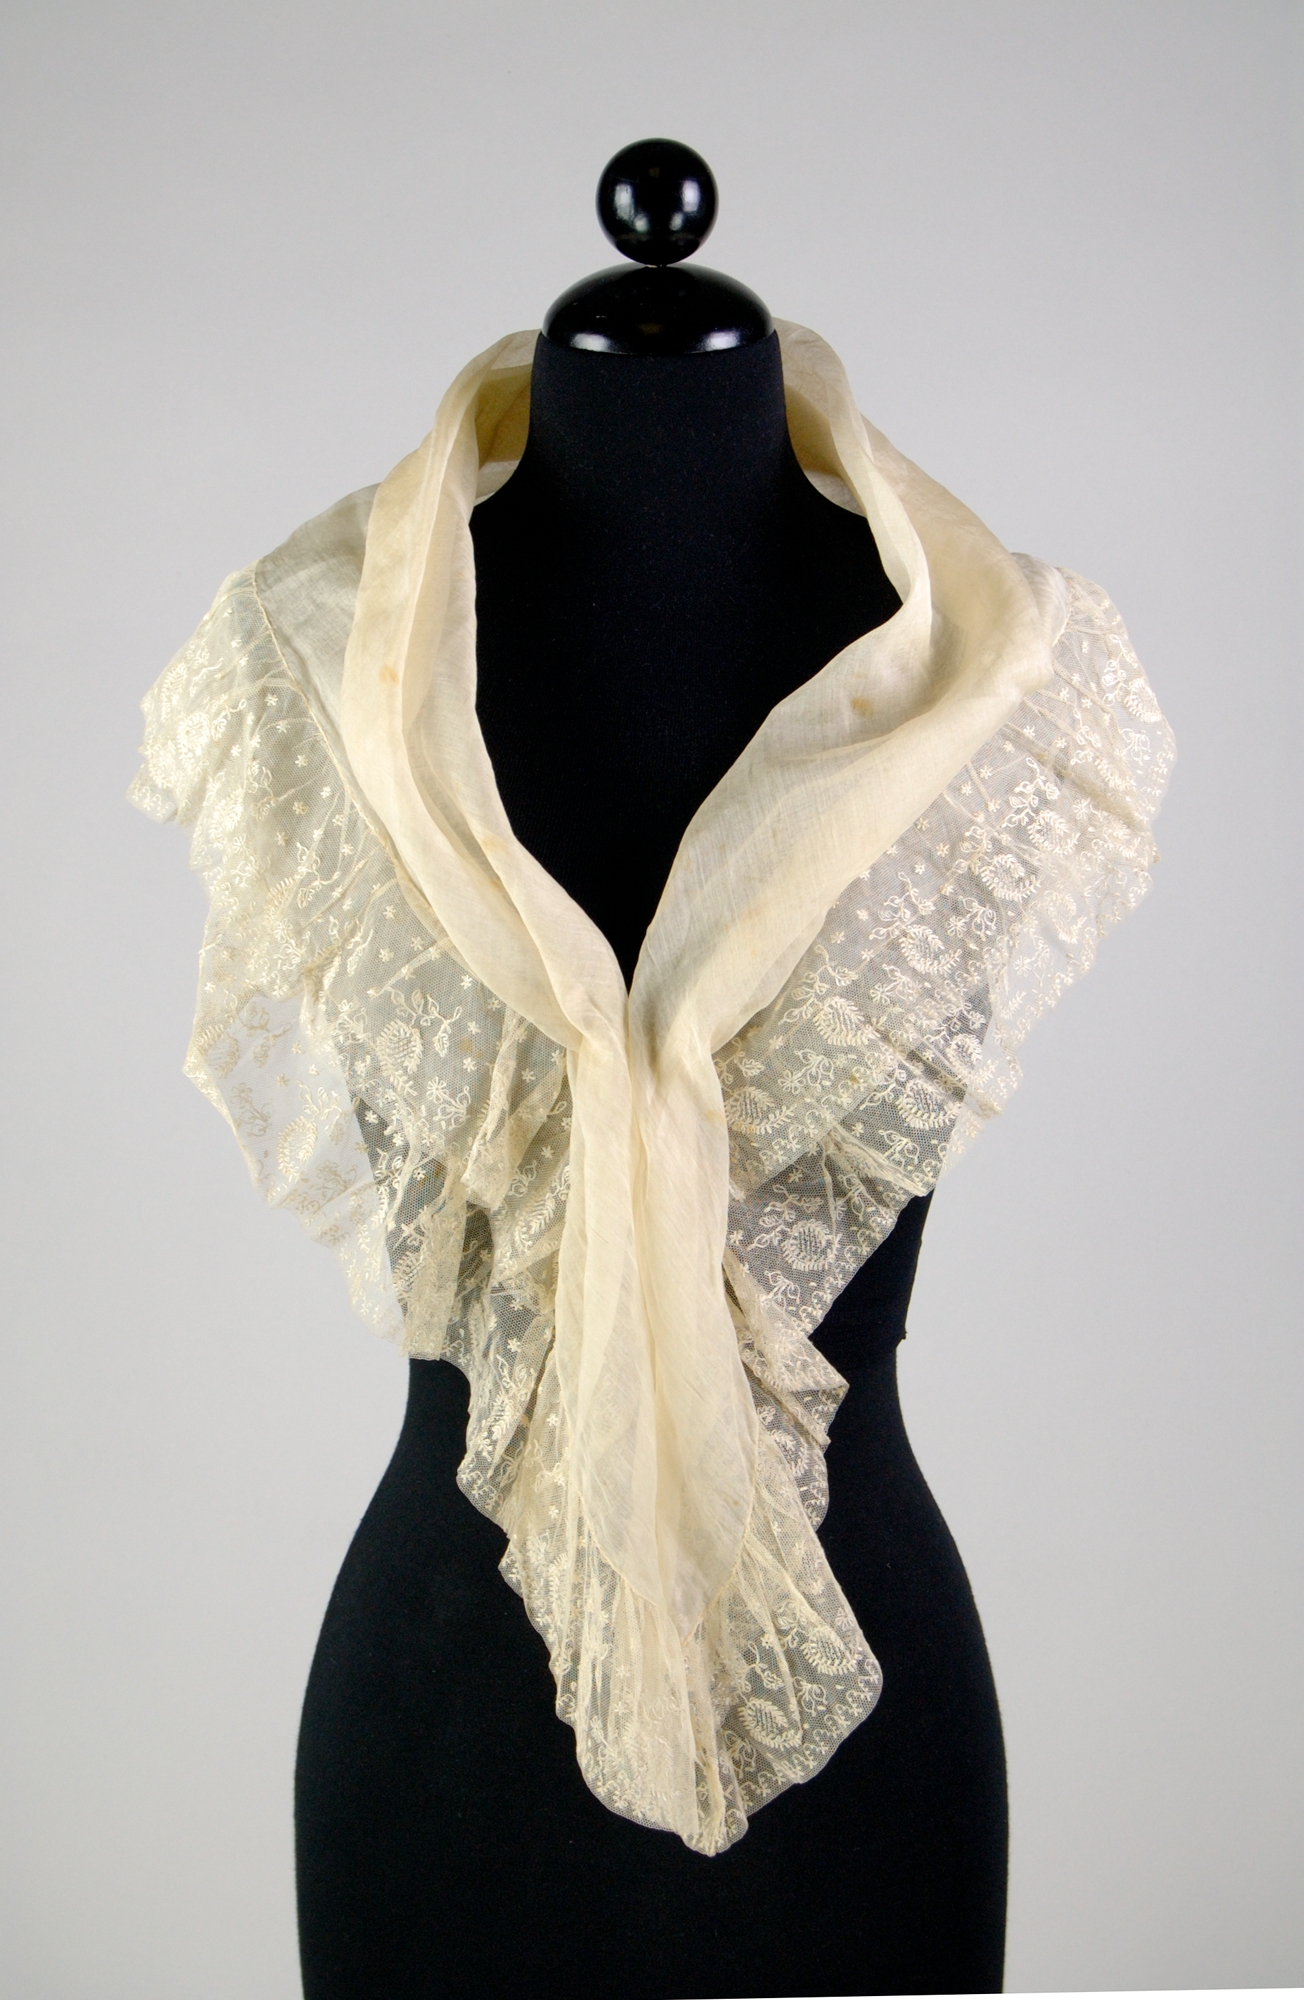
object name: fichu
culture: american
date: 1790-1810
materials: cotton